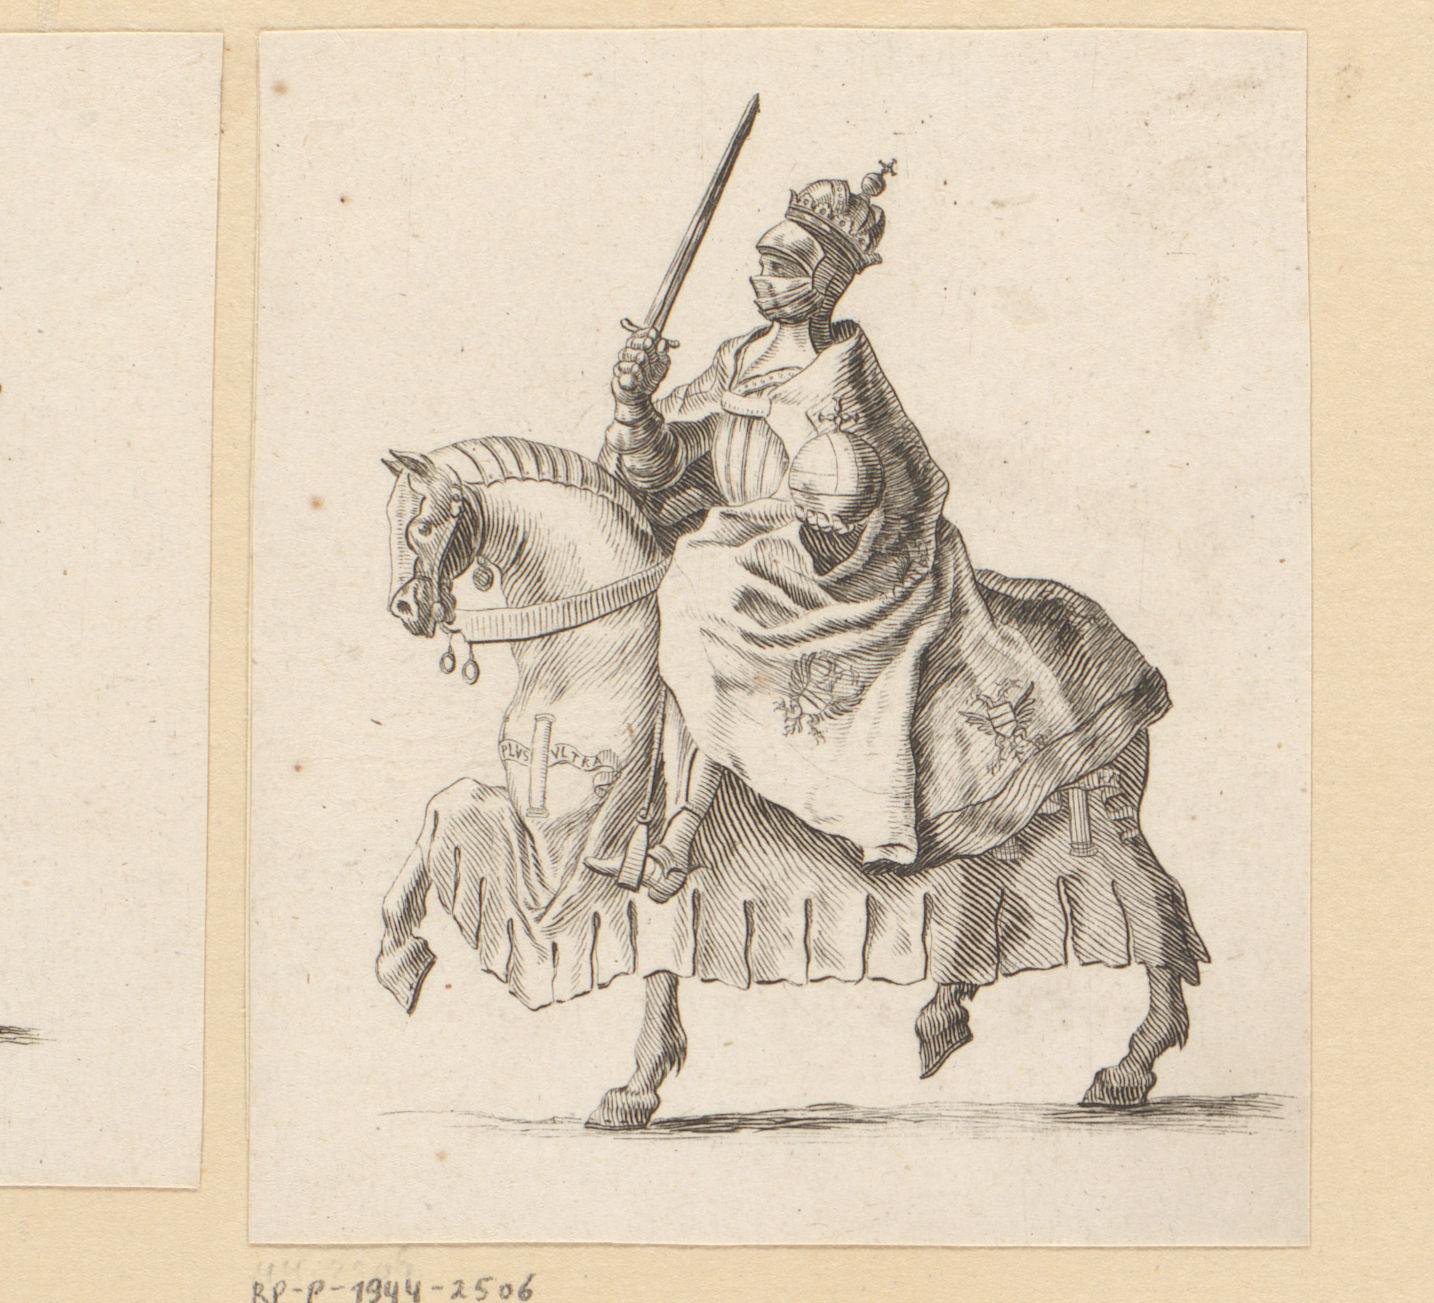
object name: print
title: Ridder te paard in wapenuitrusting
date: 1647-1714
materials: paper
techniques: engraving, etching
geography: france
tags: riding a horse, ass, or mule; rider, horseman, armour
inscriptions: collector's mark: Lugt 240